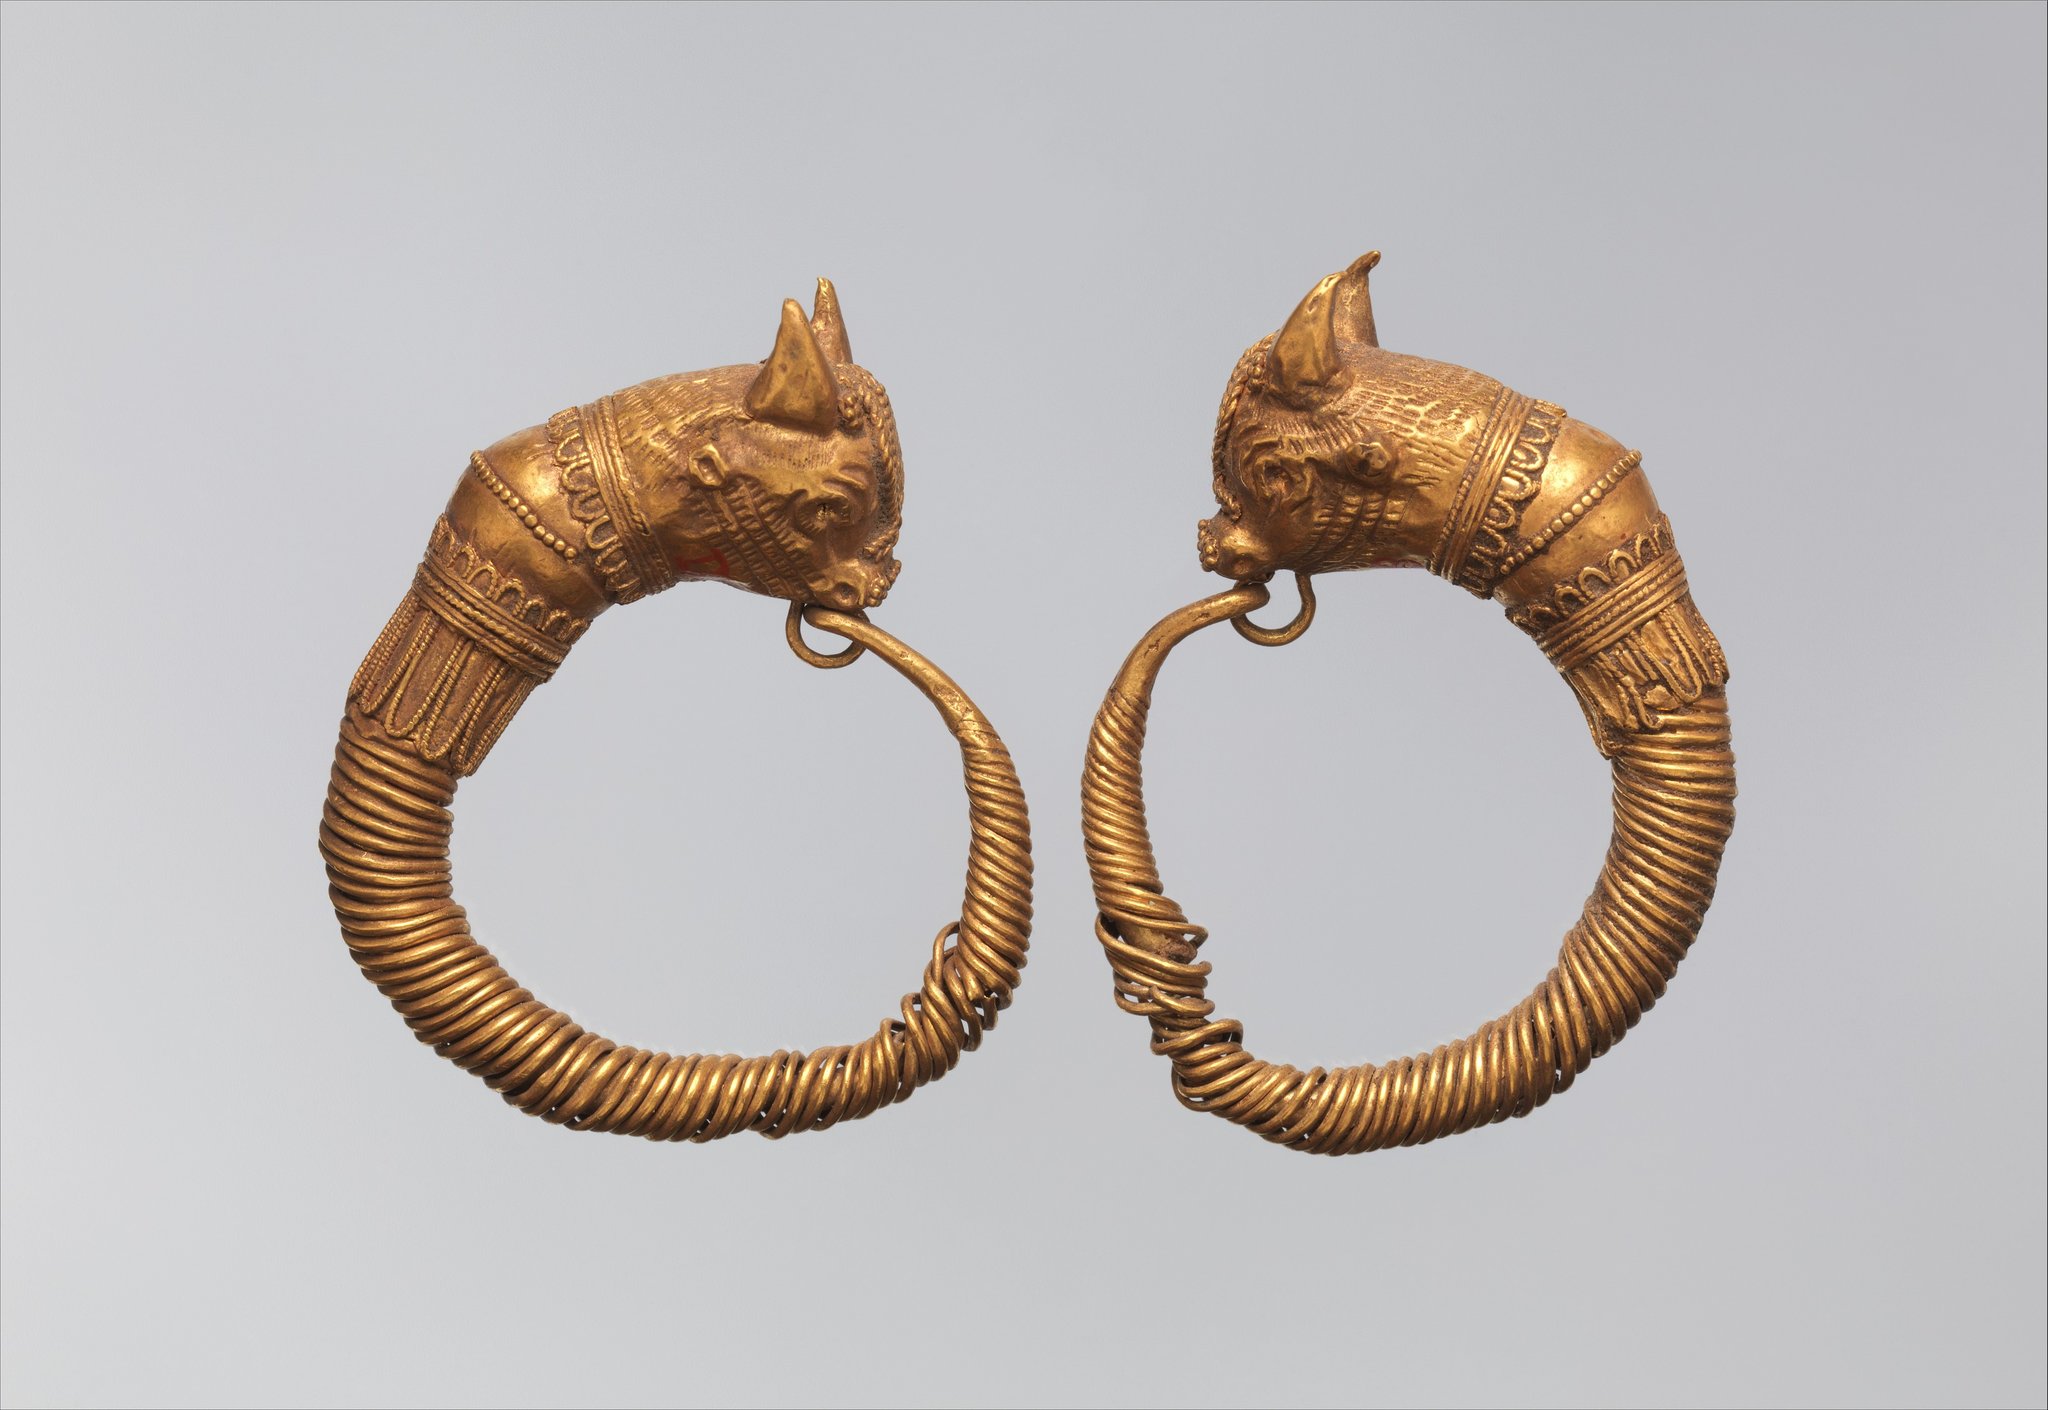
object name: earring with head of bull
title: Earring with head of a bull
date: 200-1 BCE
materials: gold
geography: egypt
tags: bulls